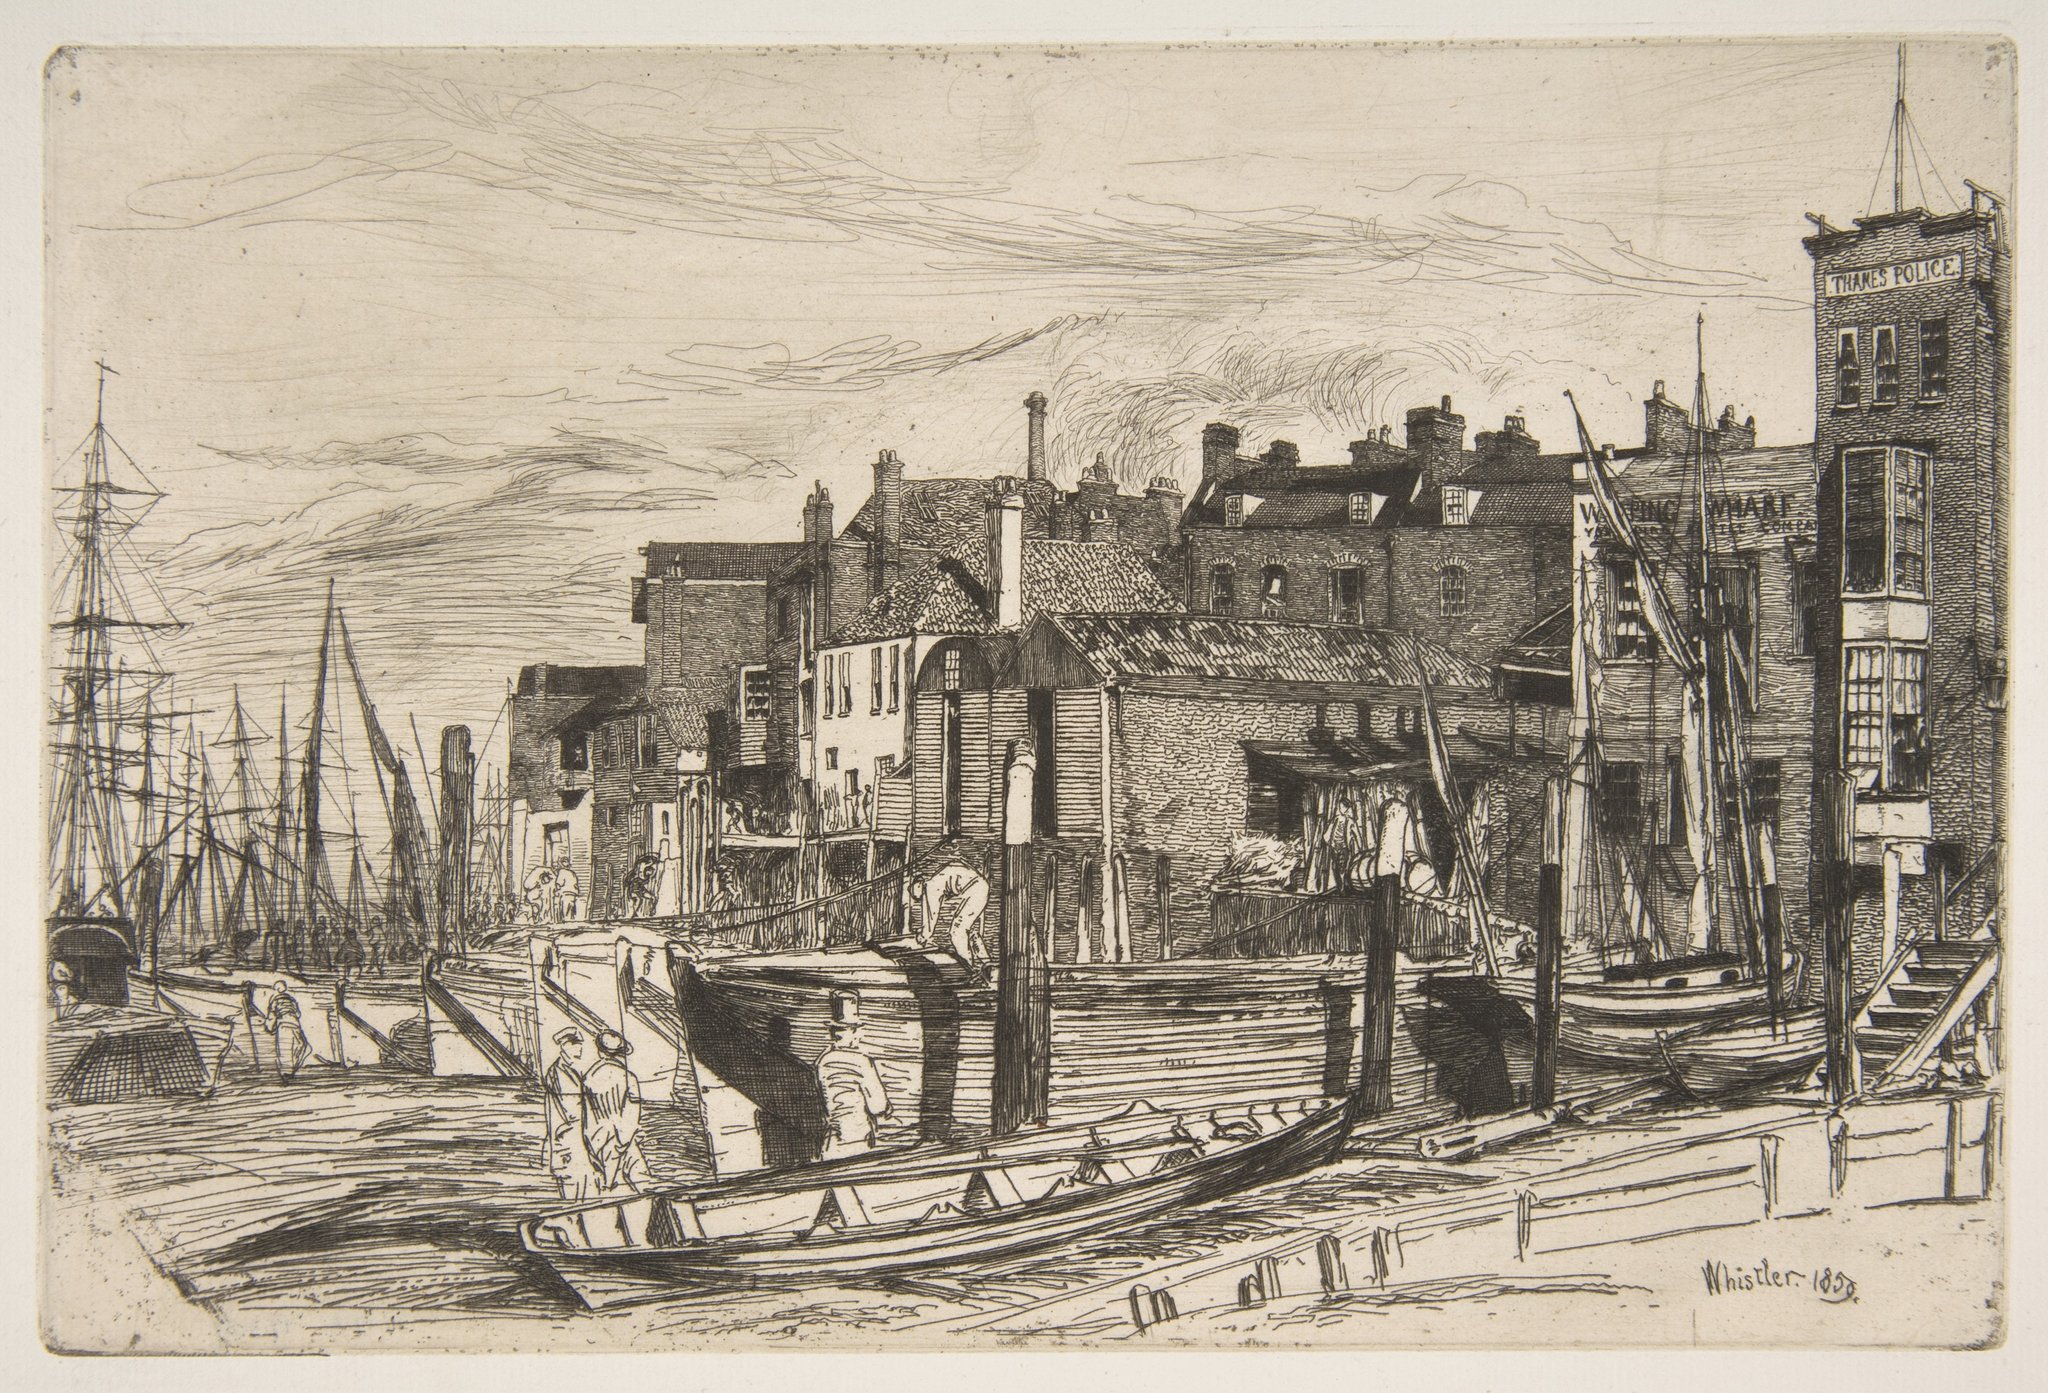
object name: print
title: Thames Police (Wapping Wharf)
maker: james mcneill whistler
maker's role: artist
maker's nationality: american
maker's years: 1834-1903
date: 1859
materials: ink, paper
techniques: etching, printing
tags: houses,rivers,police,boats